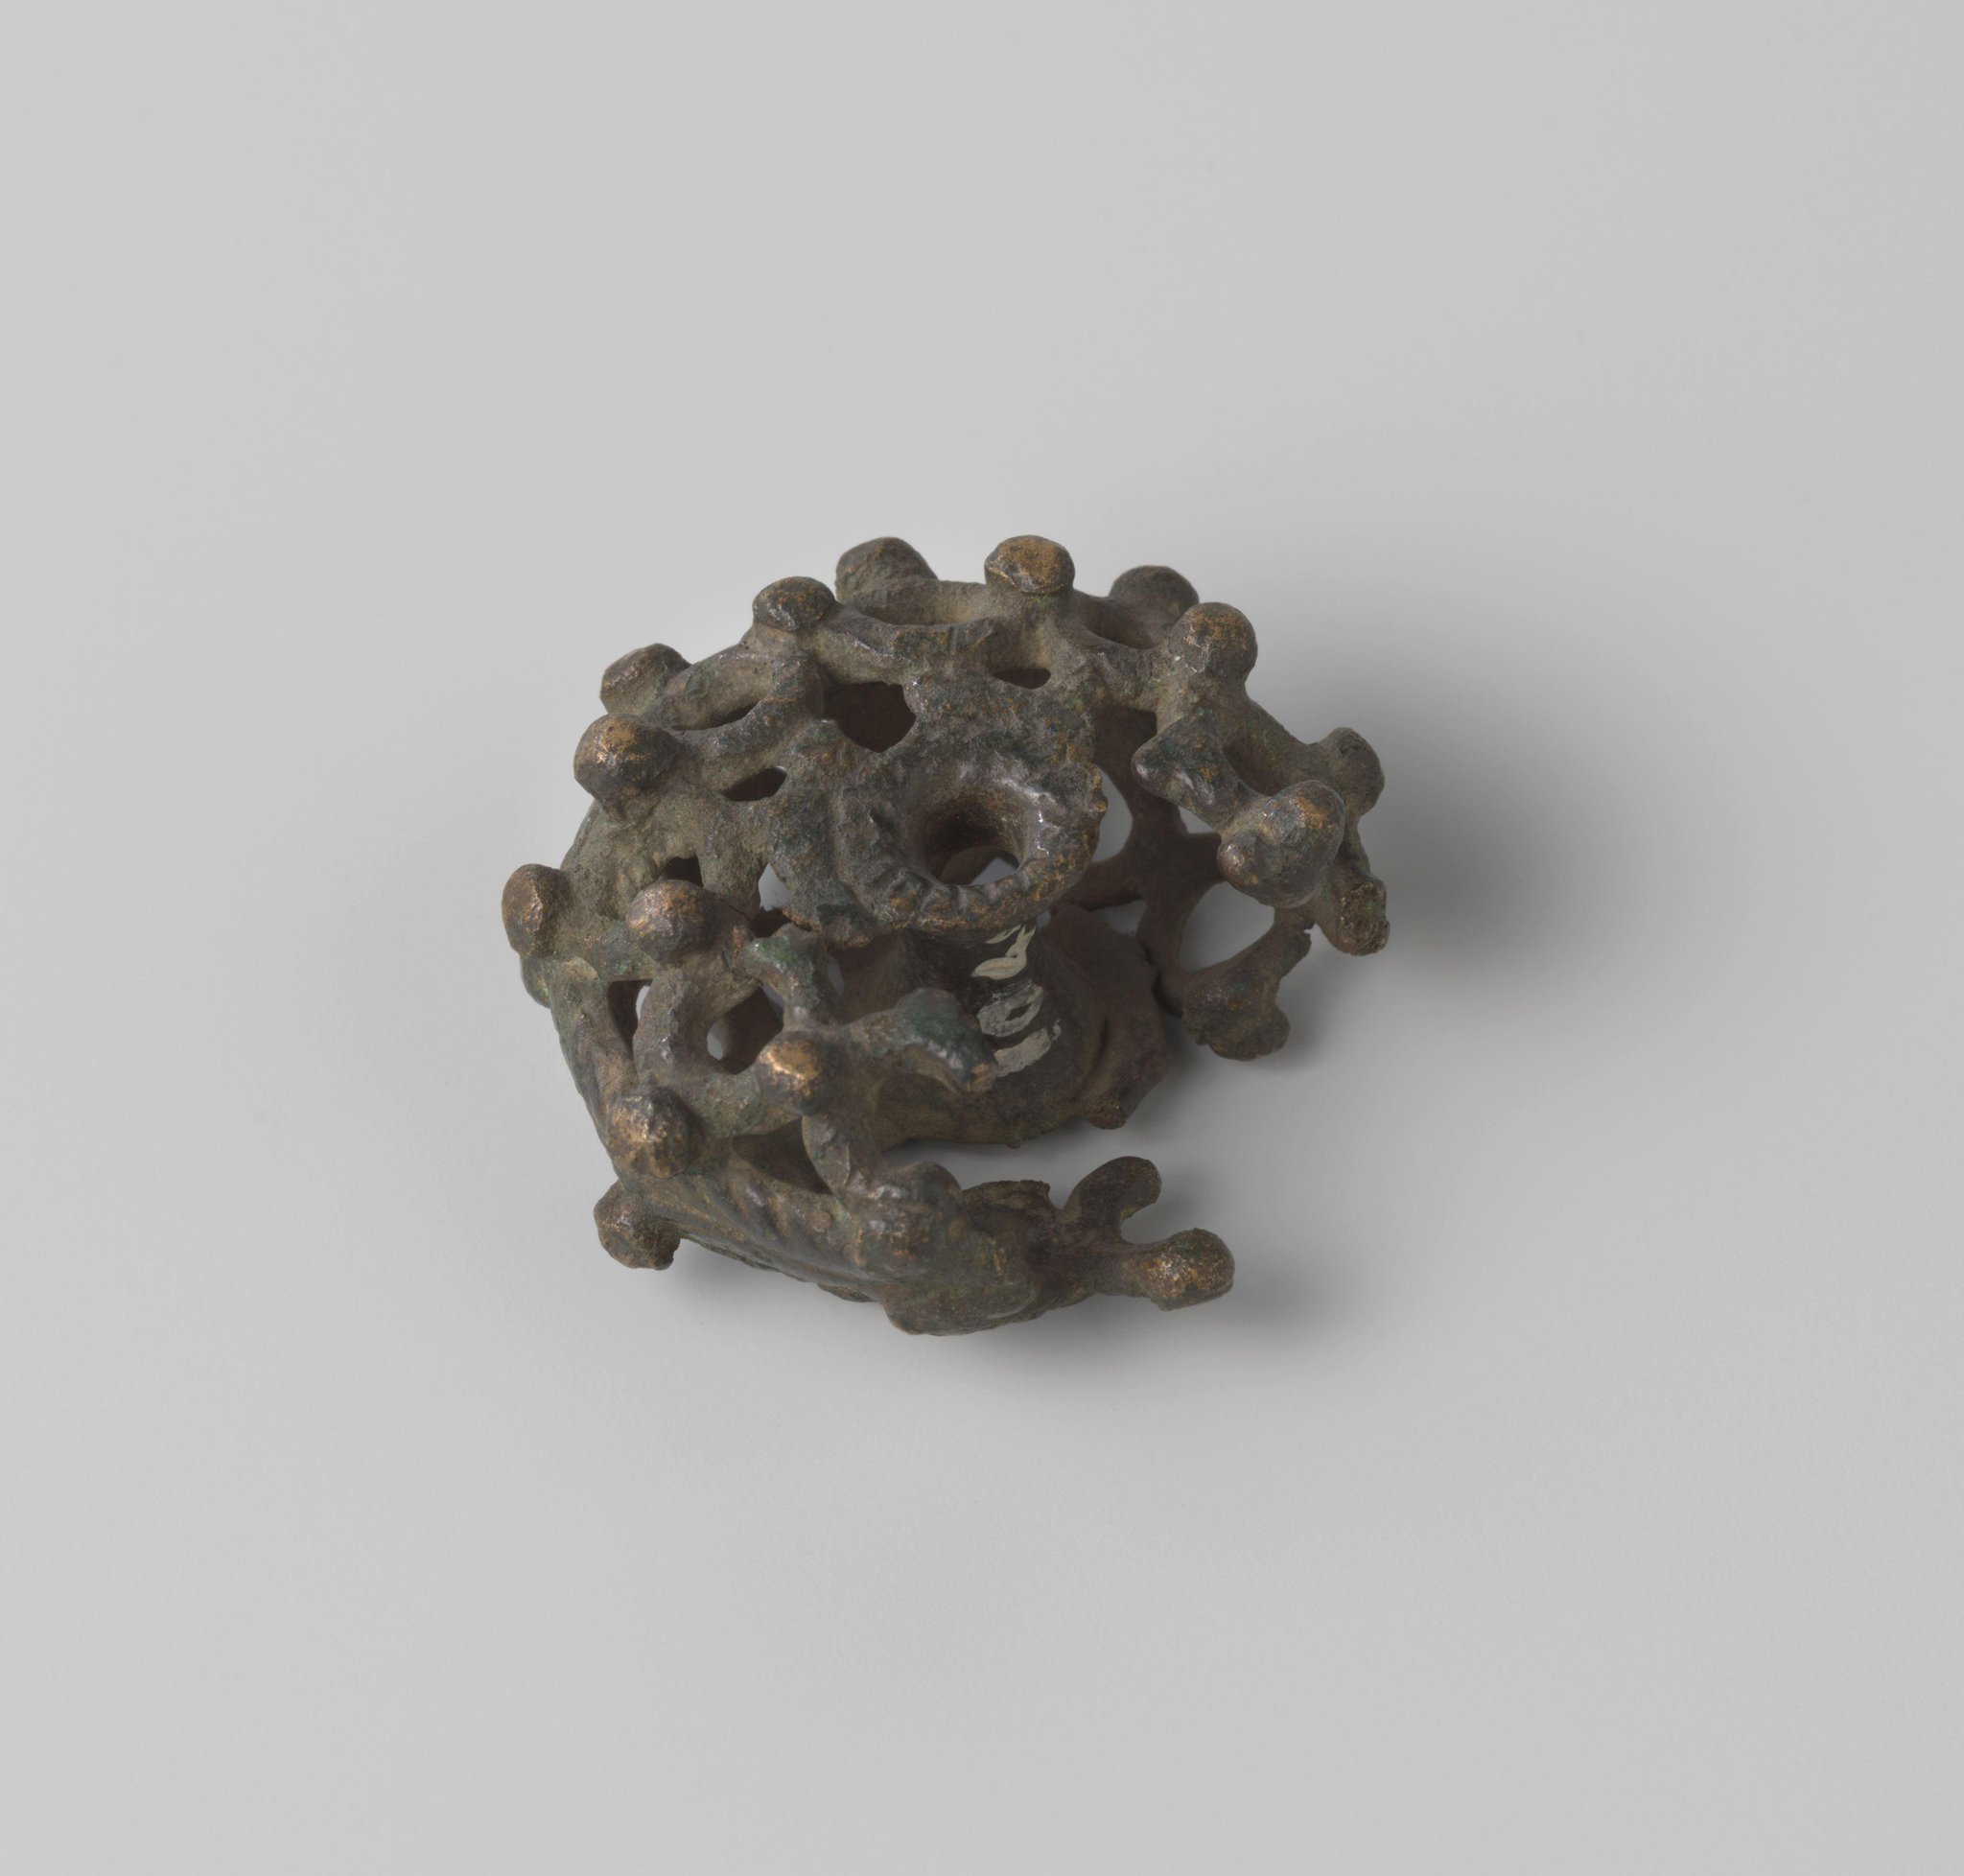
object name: knob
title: Knop (?)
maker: Anonymous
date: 1100-1200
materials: bronze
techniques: casting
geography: western europe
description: Het gegoten, opengewerkte voorwerp heeft de vorm van een nodus. In het midden een holle as, aan beide zijden afgezet met een koordrand. Rondom een dubbele koordrand, een vlechtmotief vormend. De verbinding tussen deze delen bestaat uit ringen met knoppen op de raakpunten. Een kwart deel ontbreekt. De functie is onbekend. Vermoedelijk een bodemvondst.